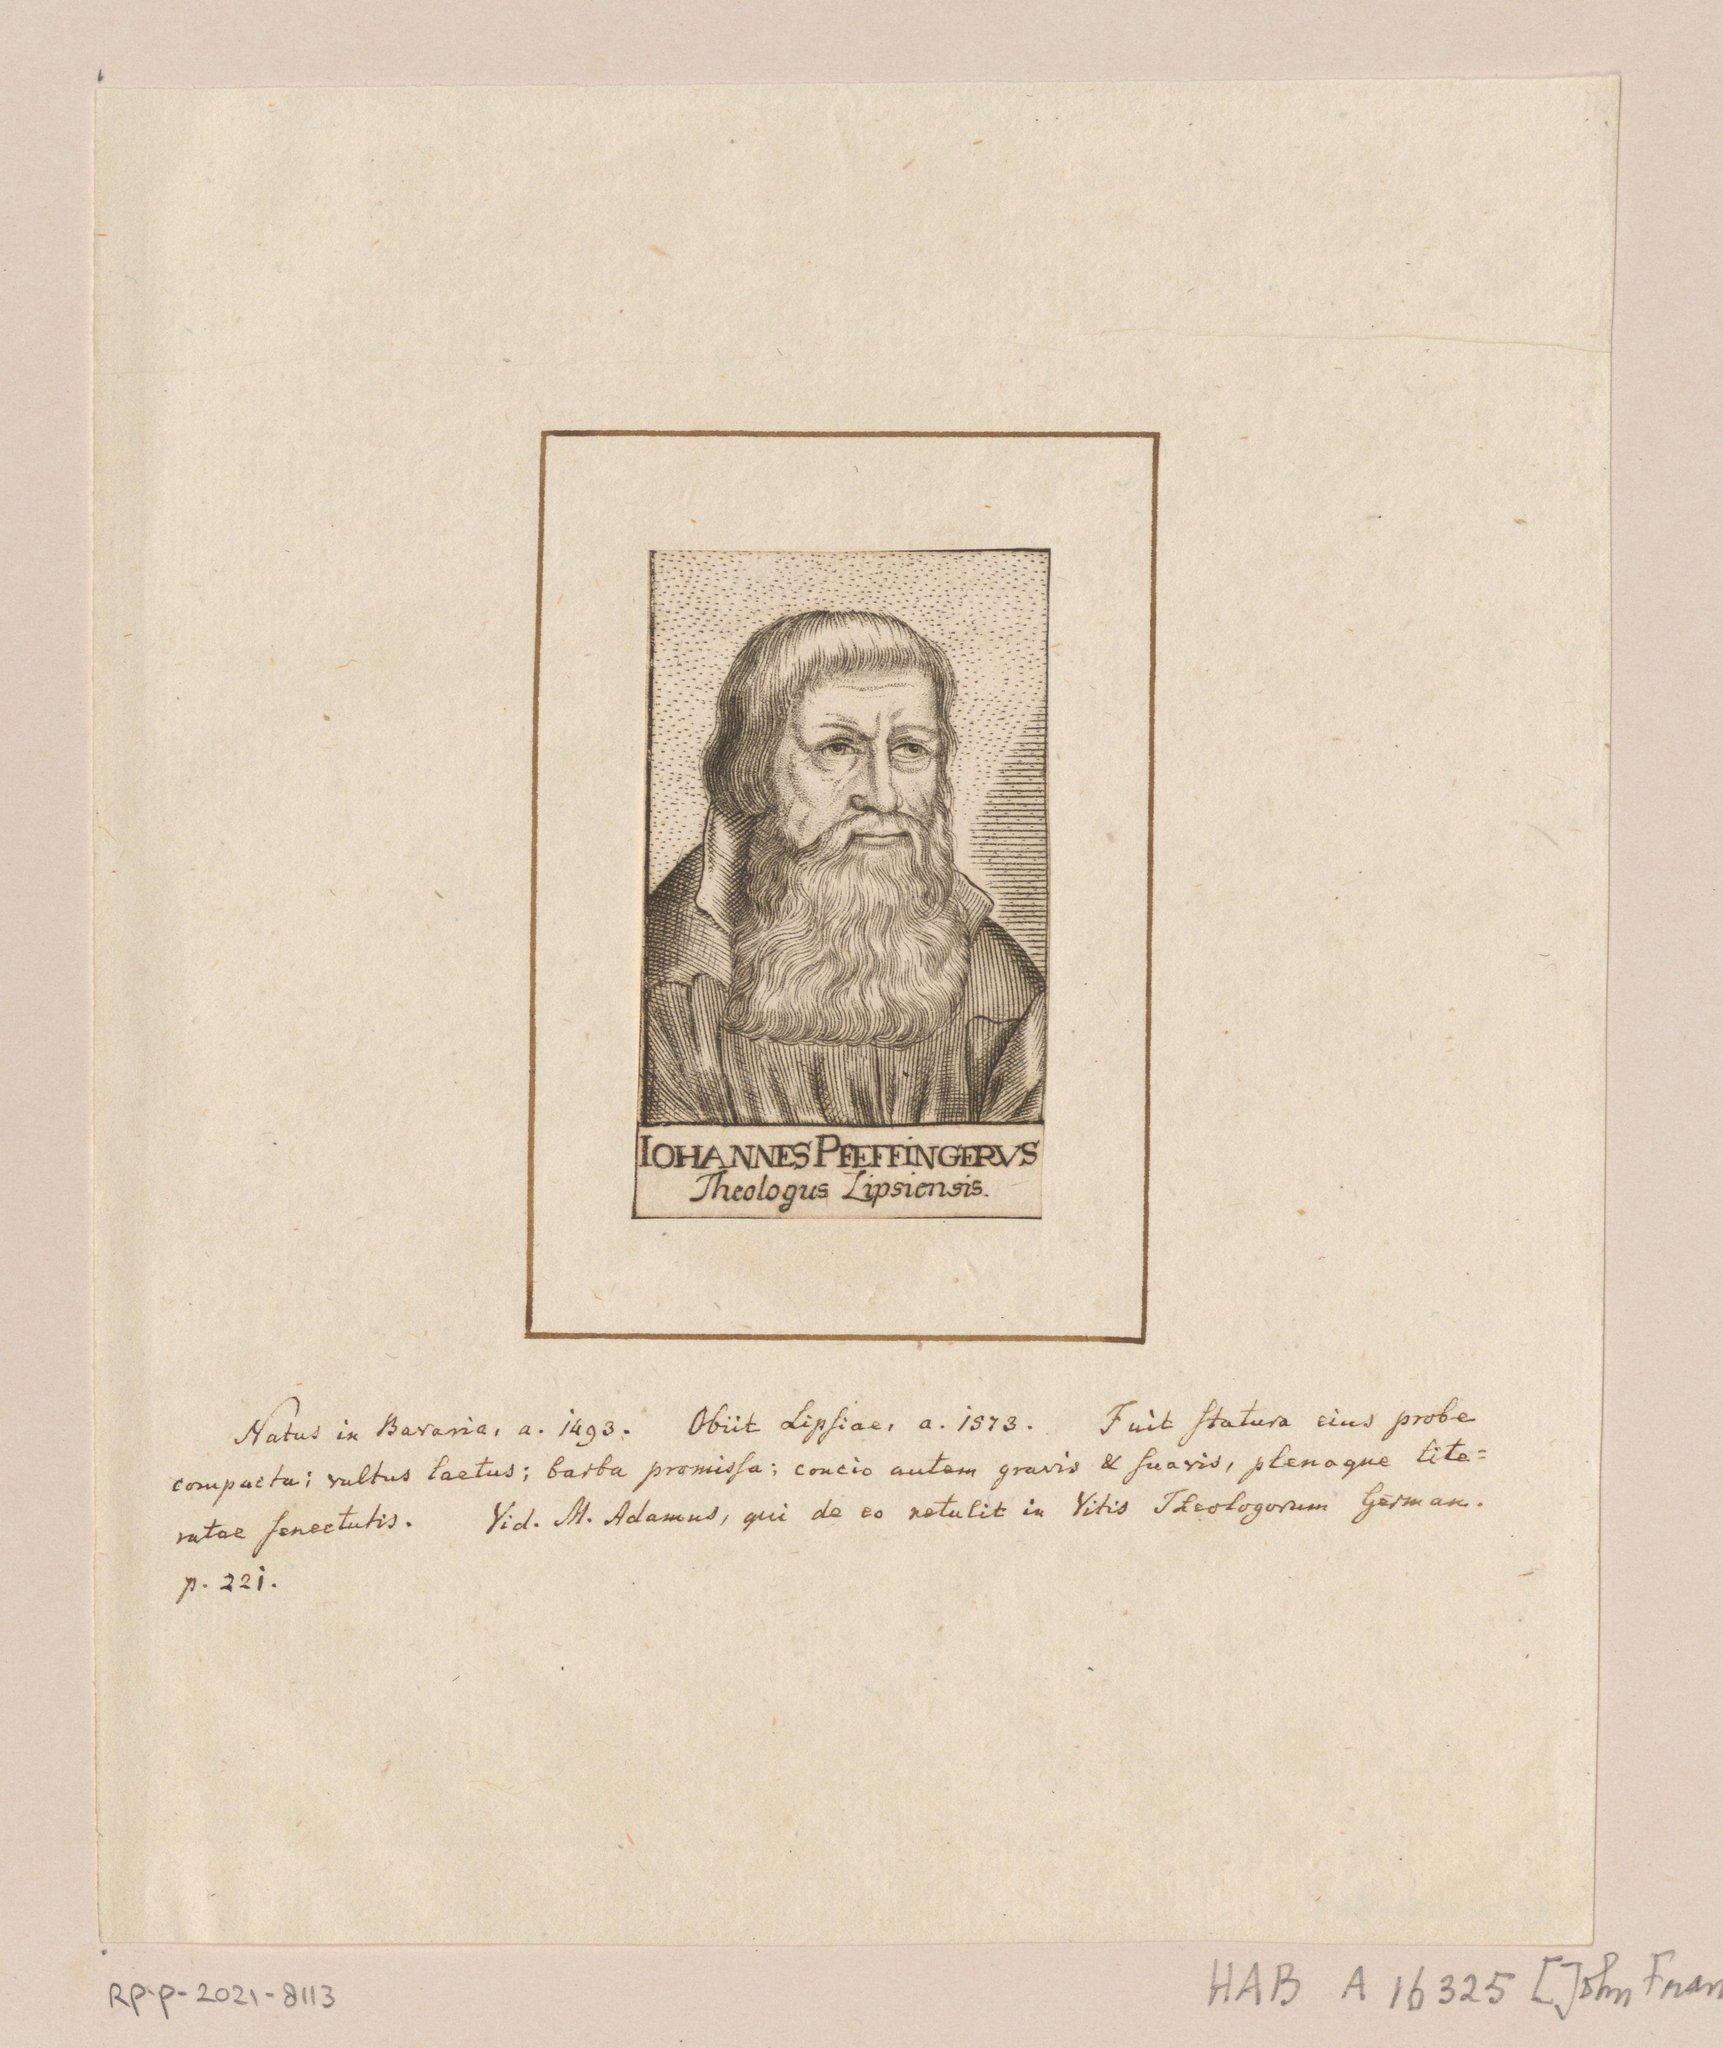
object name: book illustration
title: Portret van Johann Pfeffinger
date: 1688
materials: paper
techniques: engraving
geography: nuremberg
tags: adult man, historical persons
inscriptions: inscription: ‘Natus in Bavaria (...) p. 22i.’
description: Prent maakt deel uit van een grotere prent die later is verknipt. Prent uit: Freher, Paul. Theatrum virorum eruditione clarorum. Neurenberg: Johann Hoffmann, 1688.